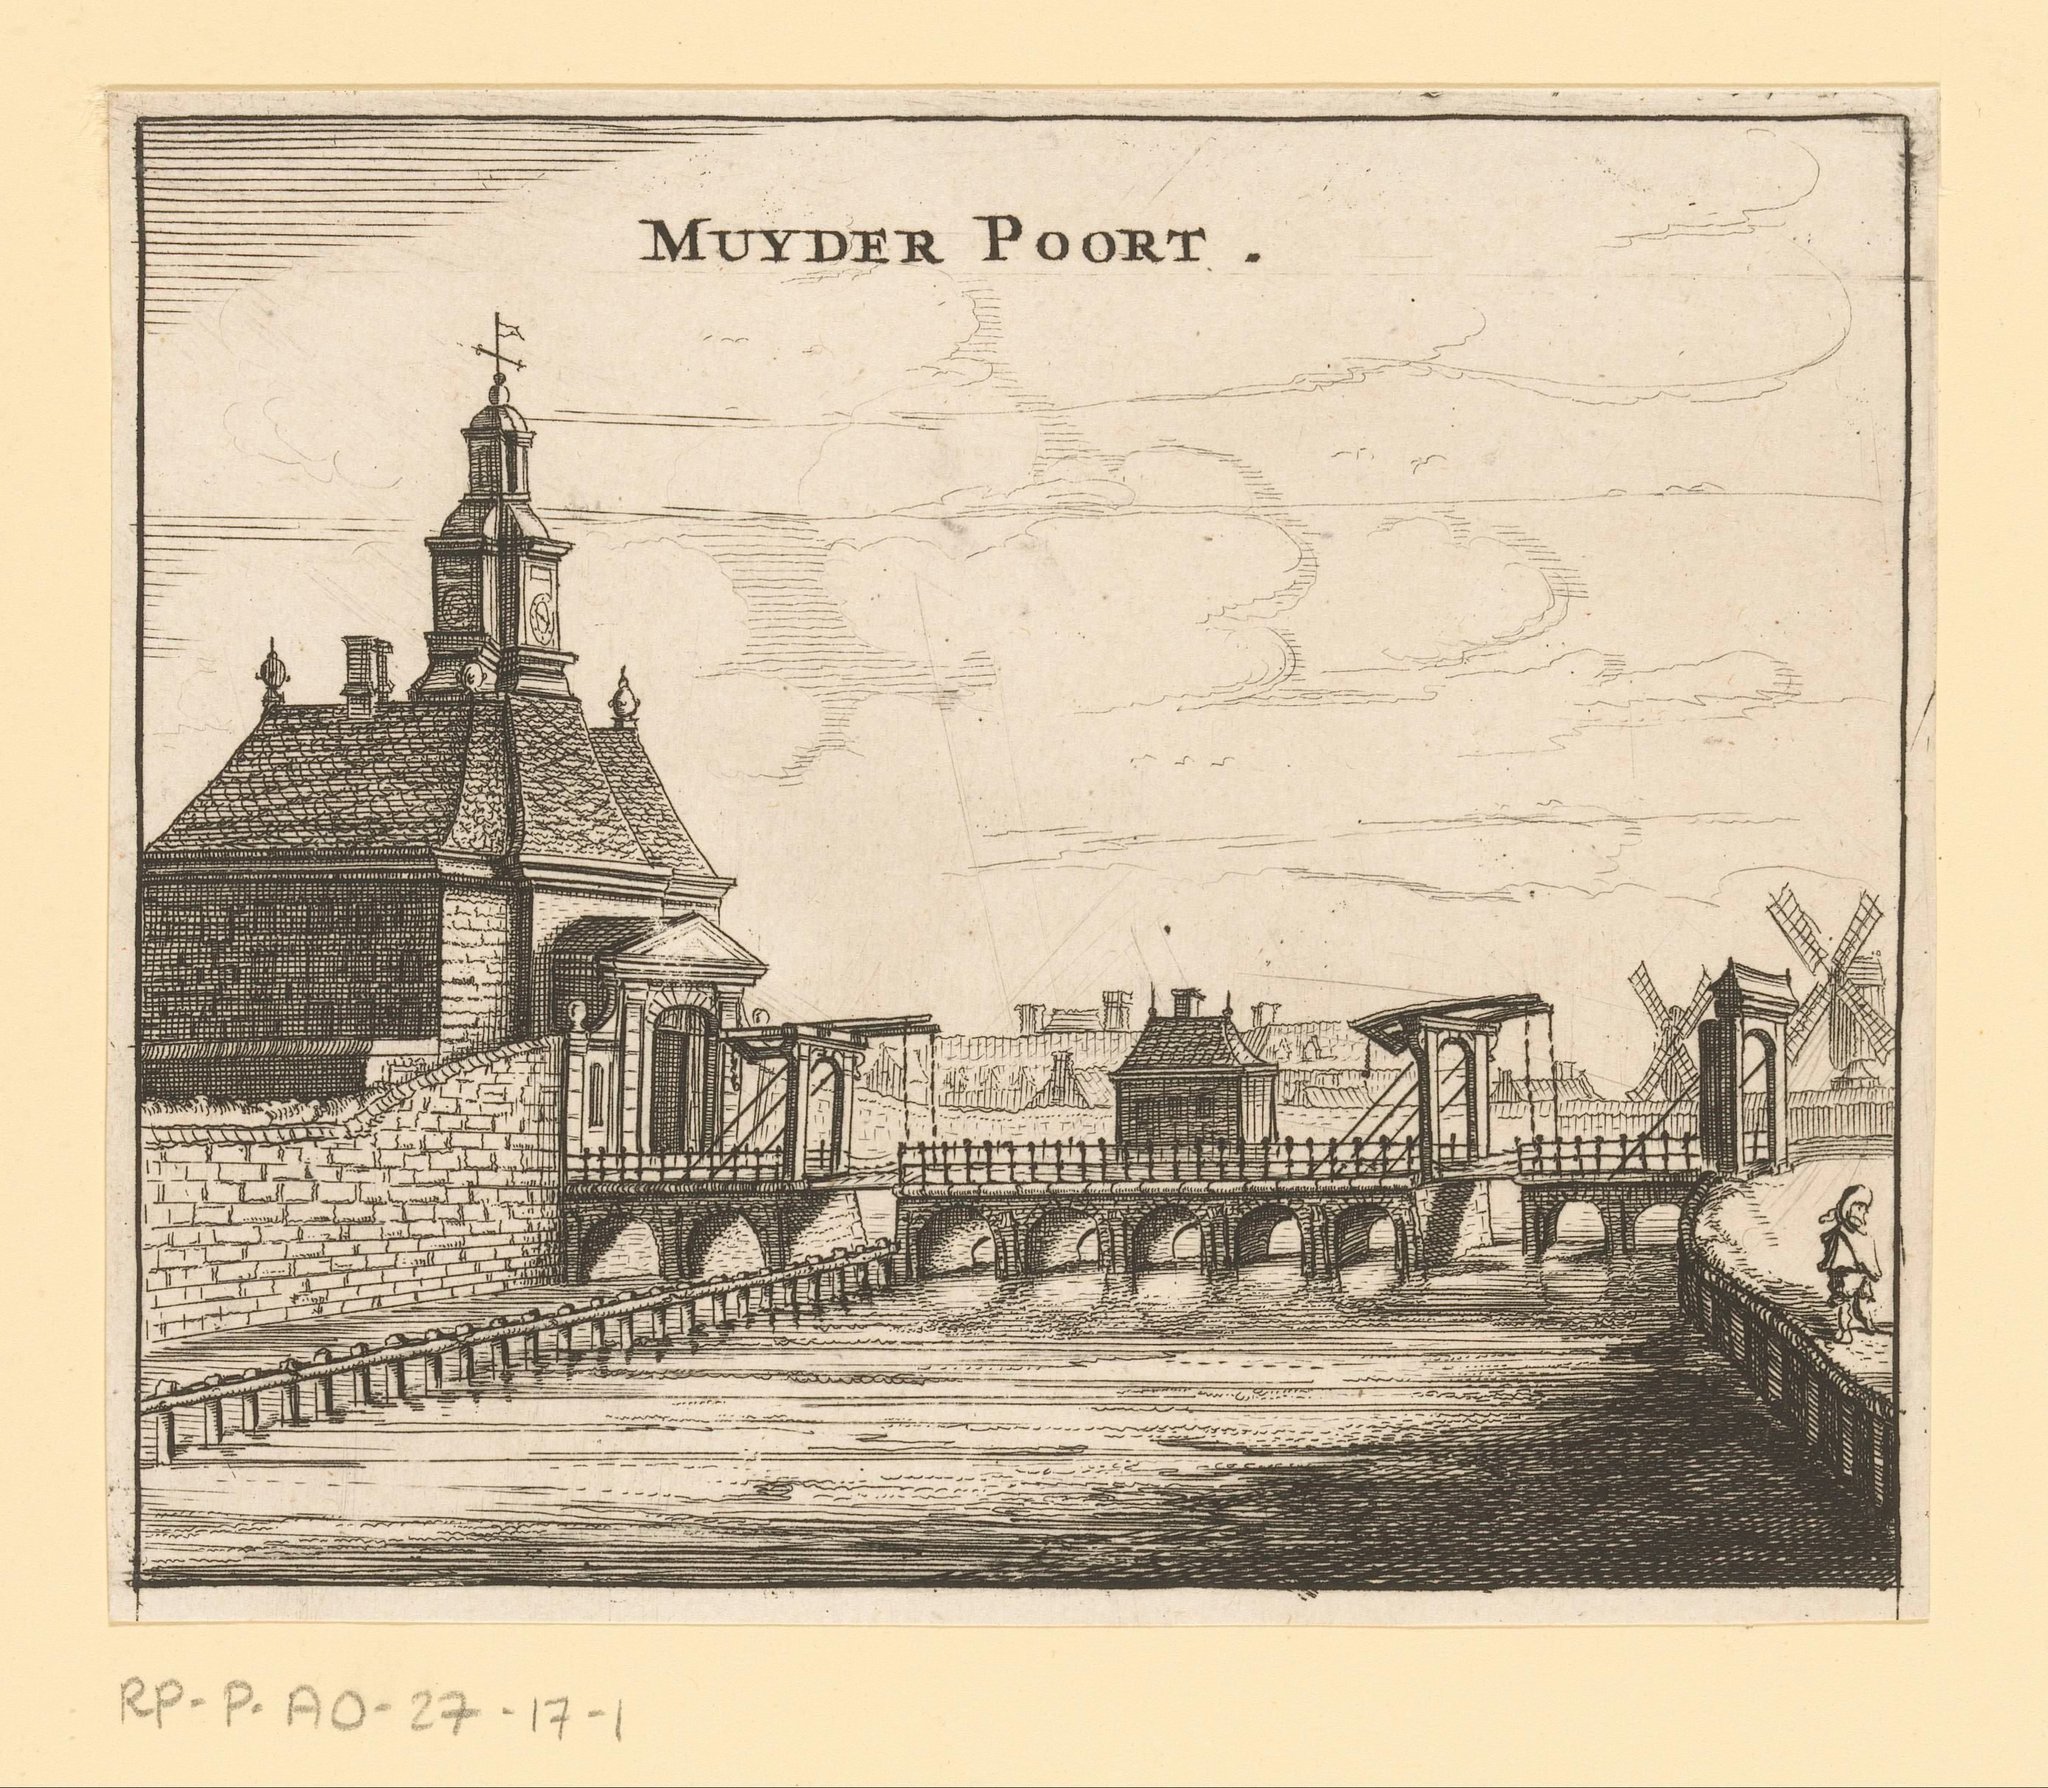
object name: print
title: Muyder Poort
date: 1664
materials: paper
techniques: engraving, etching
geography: amsterdam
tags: bridge, city-gate, canal (+ landscape with figures, staffage)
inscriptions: collector's mark: Lugt 195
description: Huidige staat van prent ook gebruikt in: Fockens, Melchior. Beschrijving Der wijdt-vermaarde Koop-stadt Amstelredam, Van haar eerste beginselen, zedert den Jare 1203. oude Voorrechten, verscheyde Vergrootingenoude Voor-rechten, en verscheyde Vergrootingen (…). 3de druk. Amsterdam: Marcus Willemsz. Doornick, 1664. En in: Zesen, Philipp von. Beschrybung der Weidtberuhmde Kauf-Stadt Amstelredam / Beschreibung der Stadt Amsterdam darinnen von derselben ersten ursprunge bis auf gegenwartigen zustand (…). Amsterdam: Marcus Willemsz. Doornick, 1664. Tweede bekende staat (met toevoeging Franse titel) ook gebruikt in: Domselaer, Tobias en Isaac Commelin. Beschryvinge van Amsterdam : haar eerste oorspronk uyt den huyze der heeren van Aemstel en Aemstellant (…). 6 delen. Amsterdam: Marcus Willemsz van Doornick, 1665. Derde bekende staat (rechtsboven genummerd: 67) ook gebruikt in verschillende latere zeventiende- en achttiende-eeuwse publicaties.